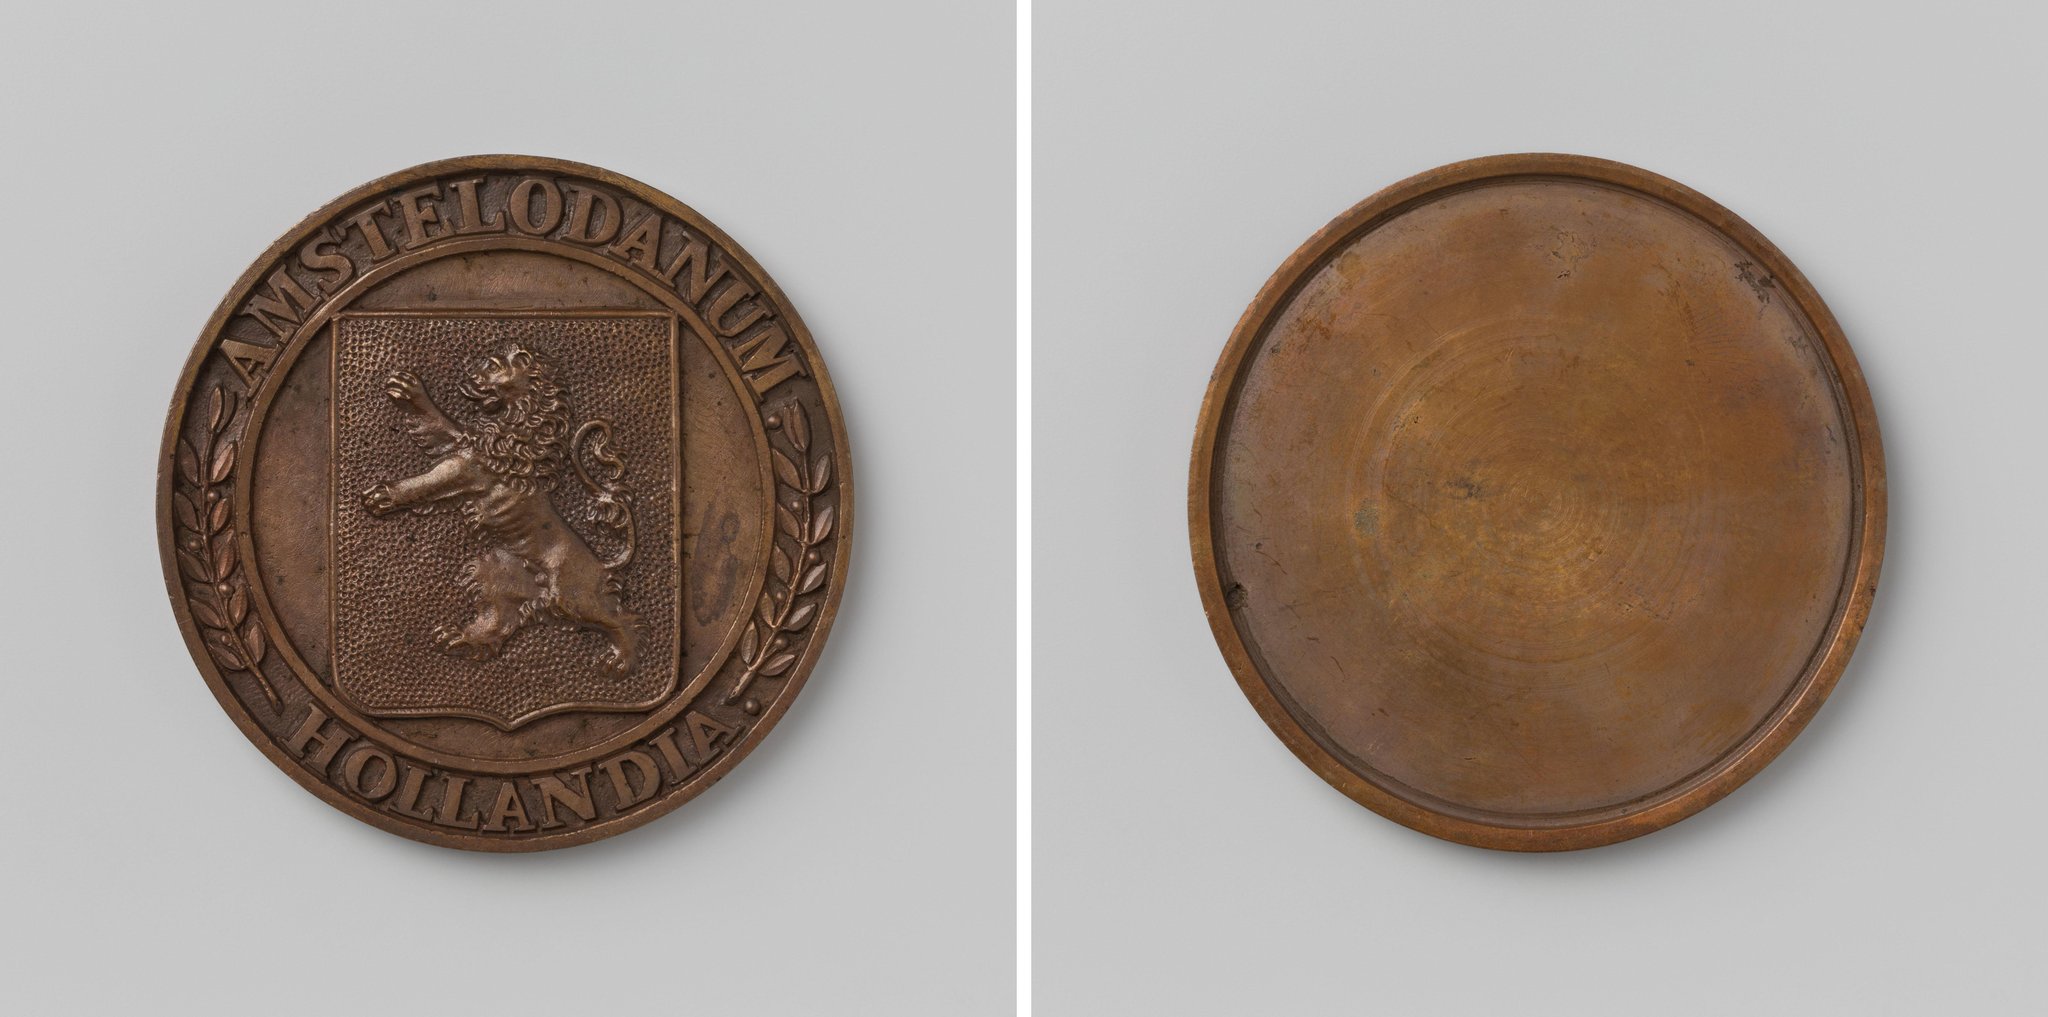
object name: medal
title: Amsterdam, provincie Holland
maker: Anonymous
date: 1815-1830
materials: bronze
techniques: striking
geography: netherlands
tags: amsterdam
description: Eenzijdige bronzen penning. Voorzijde: wapenschild binnen omschrift, onderbroken door twee bladertakken. Keerzijde: blanco